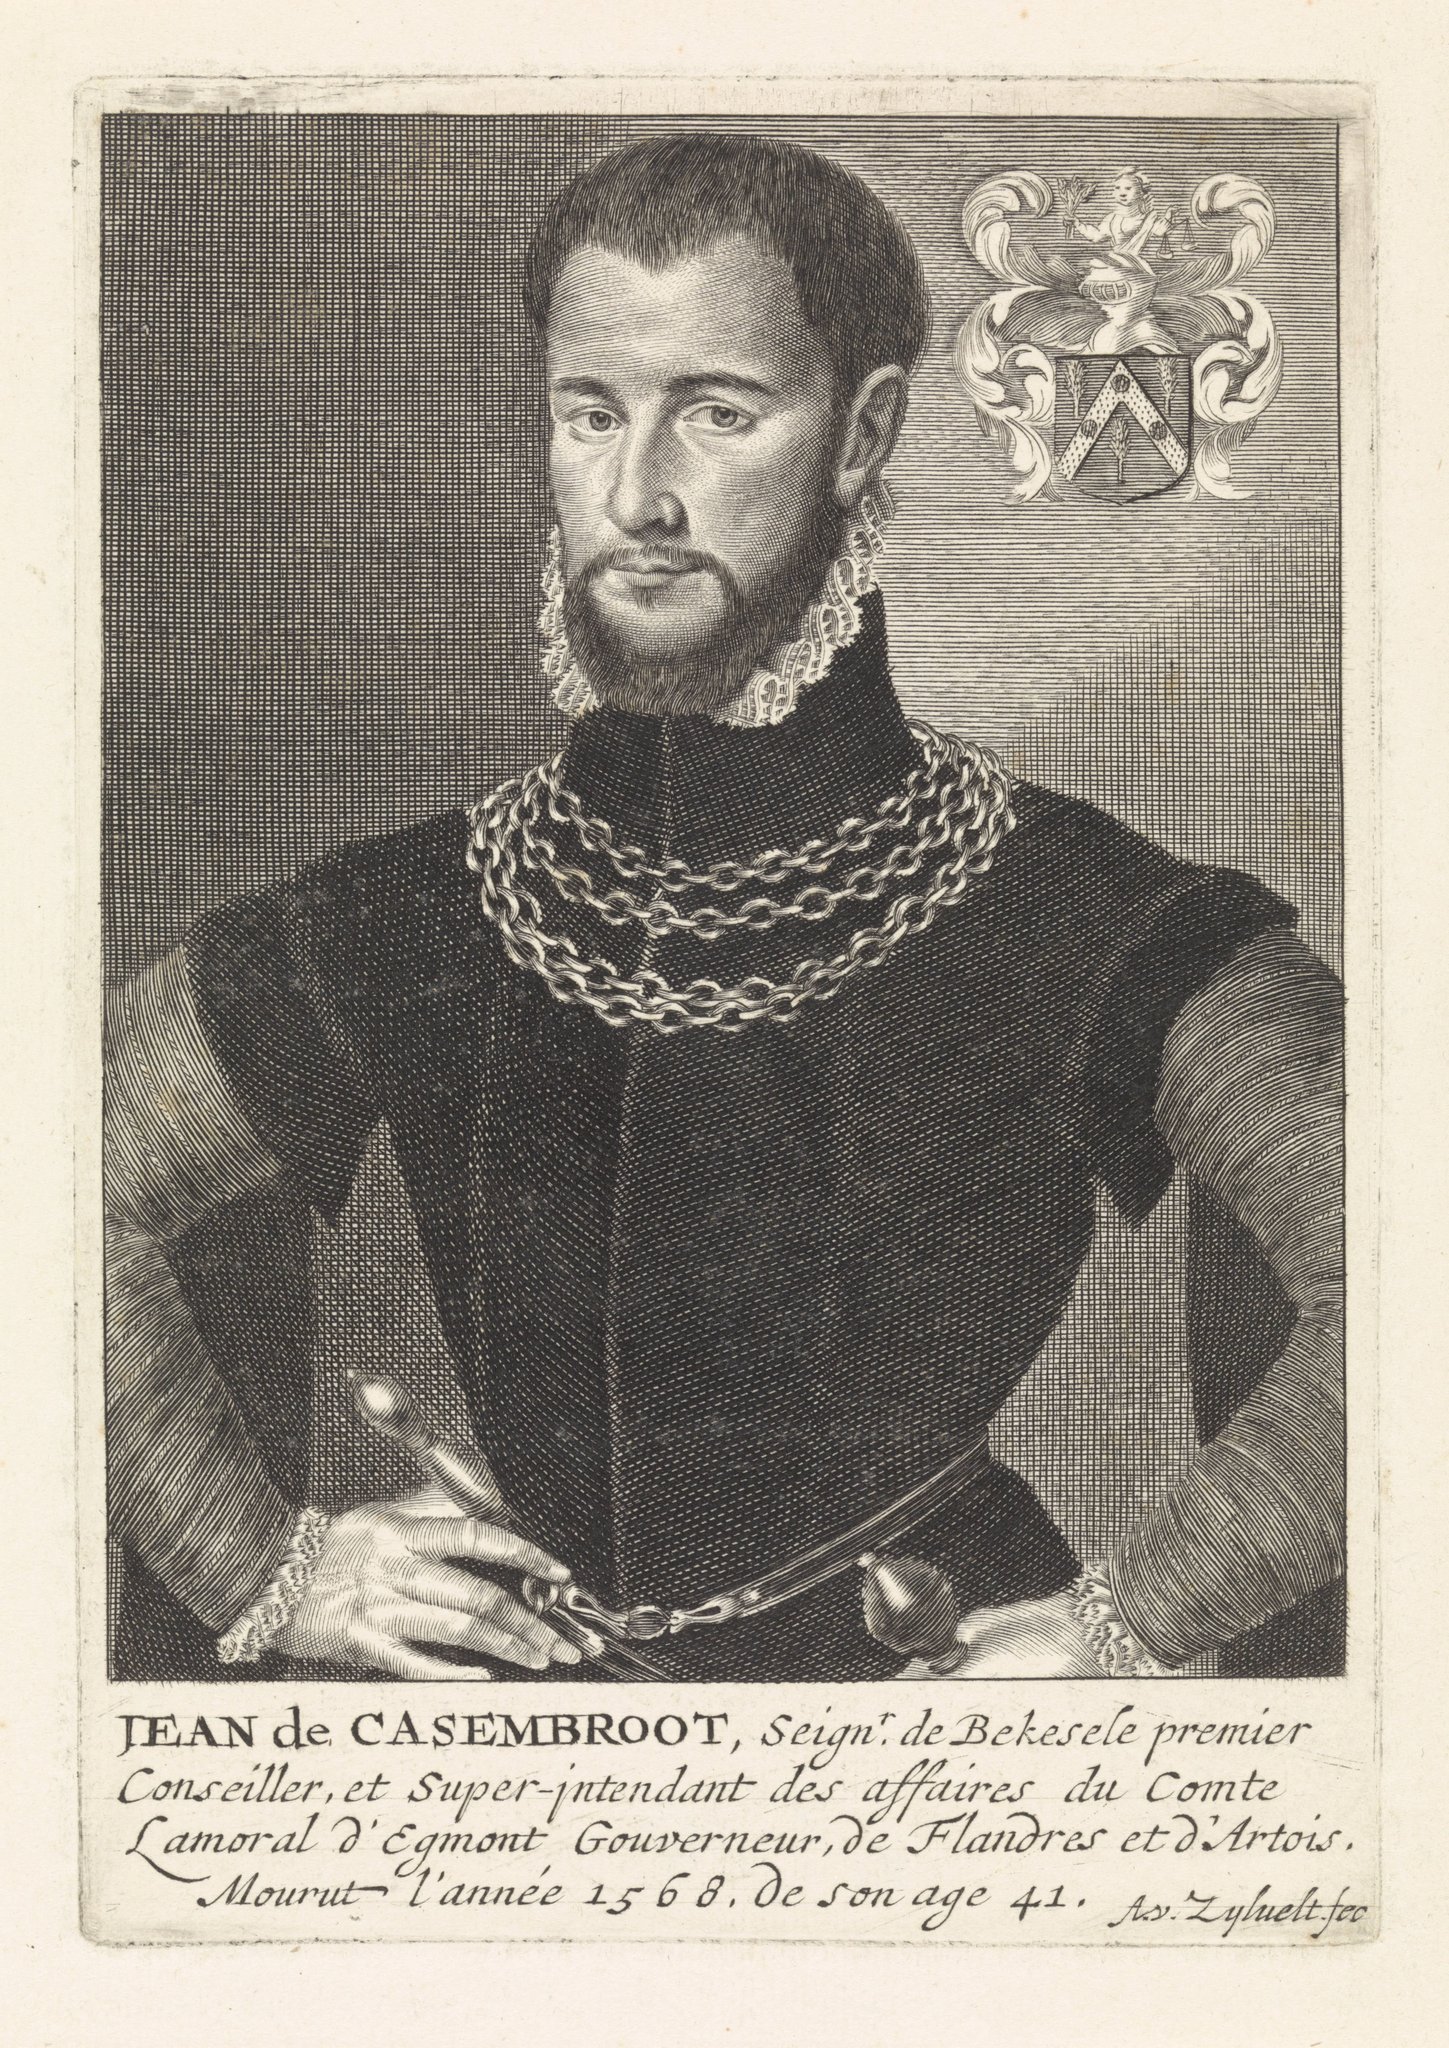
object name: print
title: Portret van Jehan de Casembroot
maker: anthony van zijlvelt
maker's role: print maker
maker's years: 1637-1715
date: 1650-1695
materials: paper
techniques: engraving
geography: amsterdam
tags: vilvoorde, raadsheer, jehan de casembroot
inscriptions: collector's mark: Lugt 240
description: Portret van Jehan de Casembroot, raadsheer en secretaris van Lamoraal graaf van Egmond. Rechtsboven zijn wapenschild.